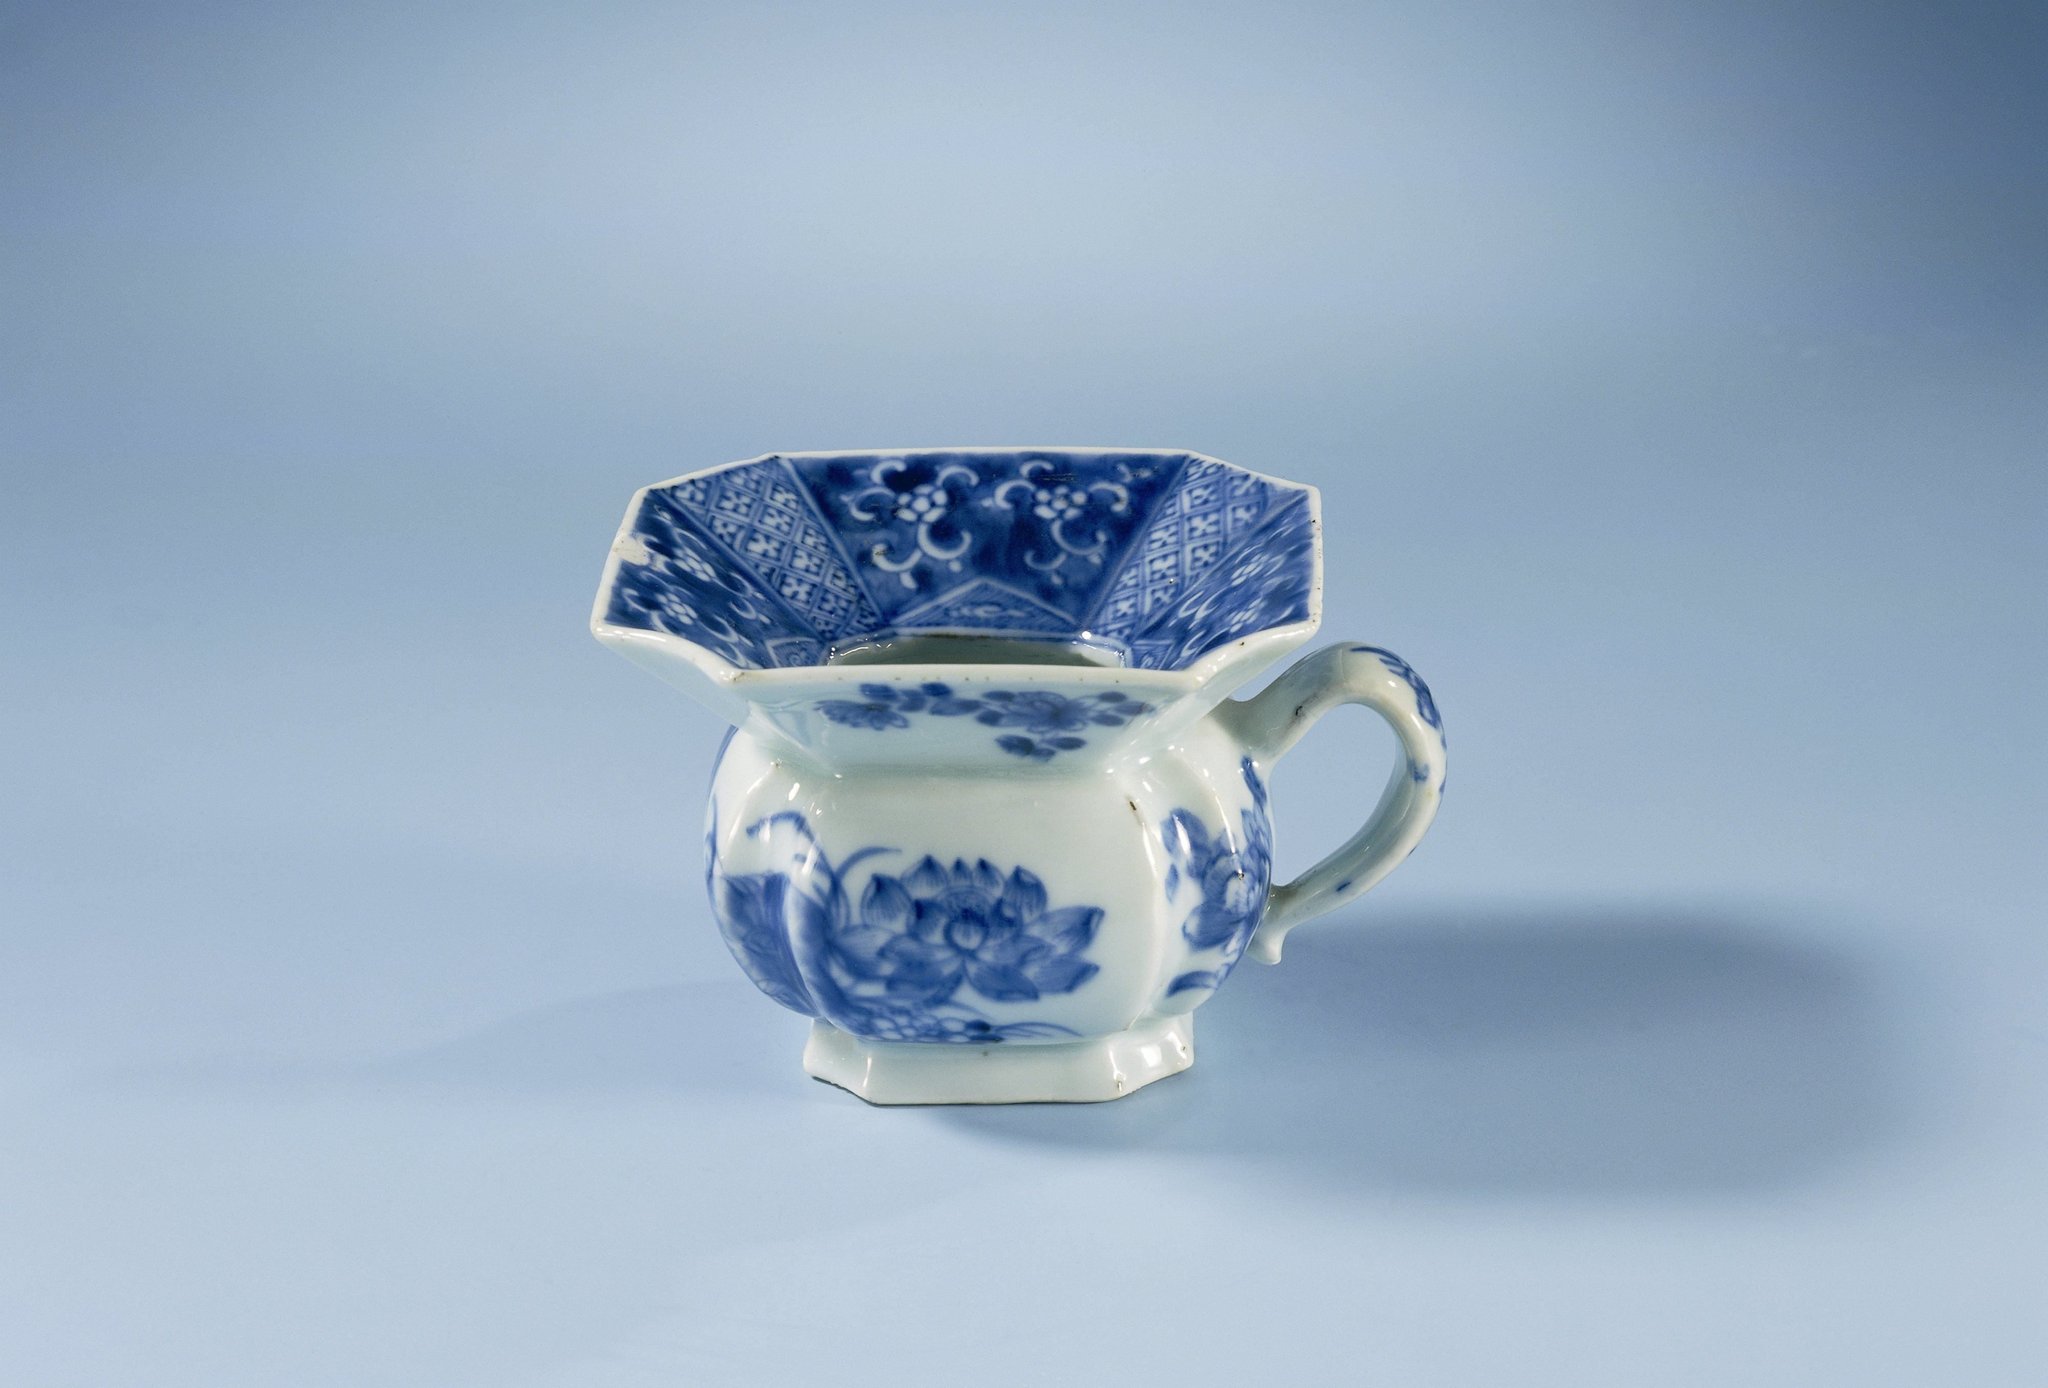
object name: spittoon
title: Octagonal spittoon with lotus plants and willow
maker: Anonymous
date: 1720-1725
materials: cobalt, glaze, paint, porcelain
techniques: firing, forming, turning, vitrification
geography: china